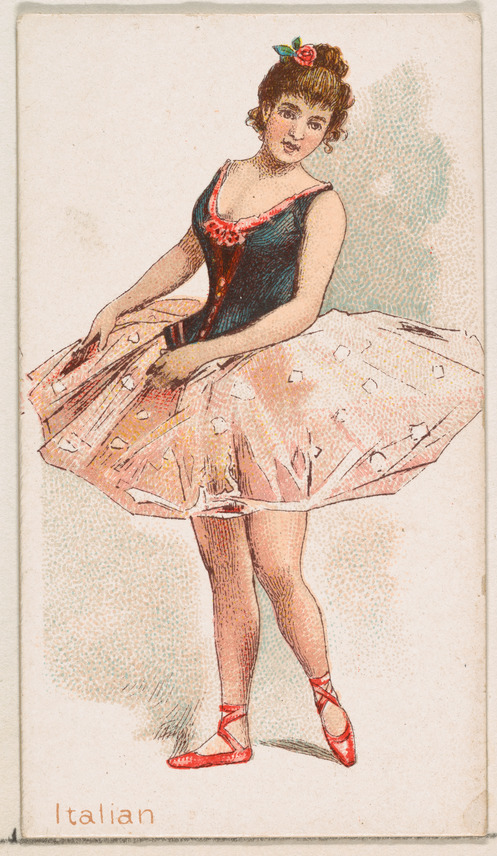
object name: print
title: Italian Dancer, from the Dancing Women series (N186) issued by Wm. S. Kimball & Co.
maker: william s. kimball & company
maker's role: publisher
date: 1889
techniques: color lithograph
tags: women,dancers